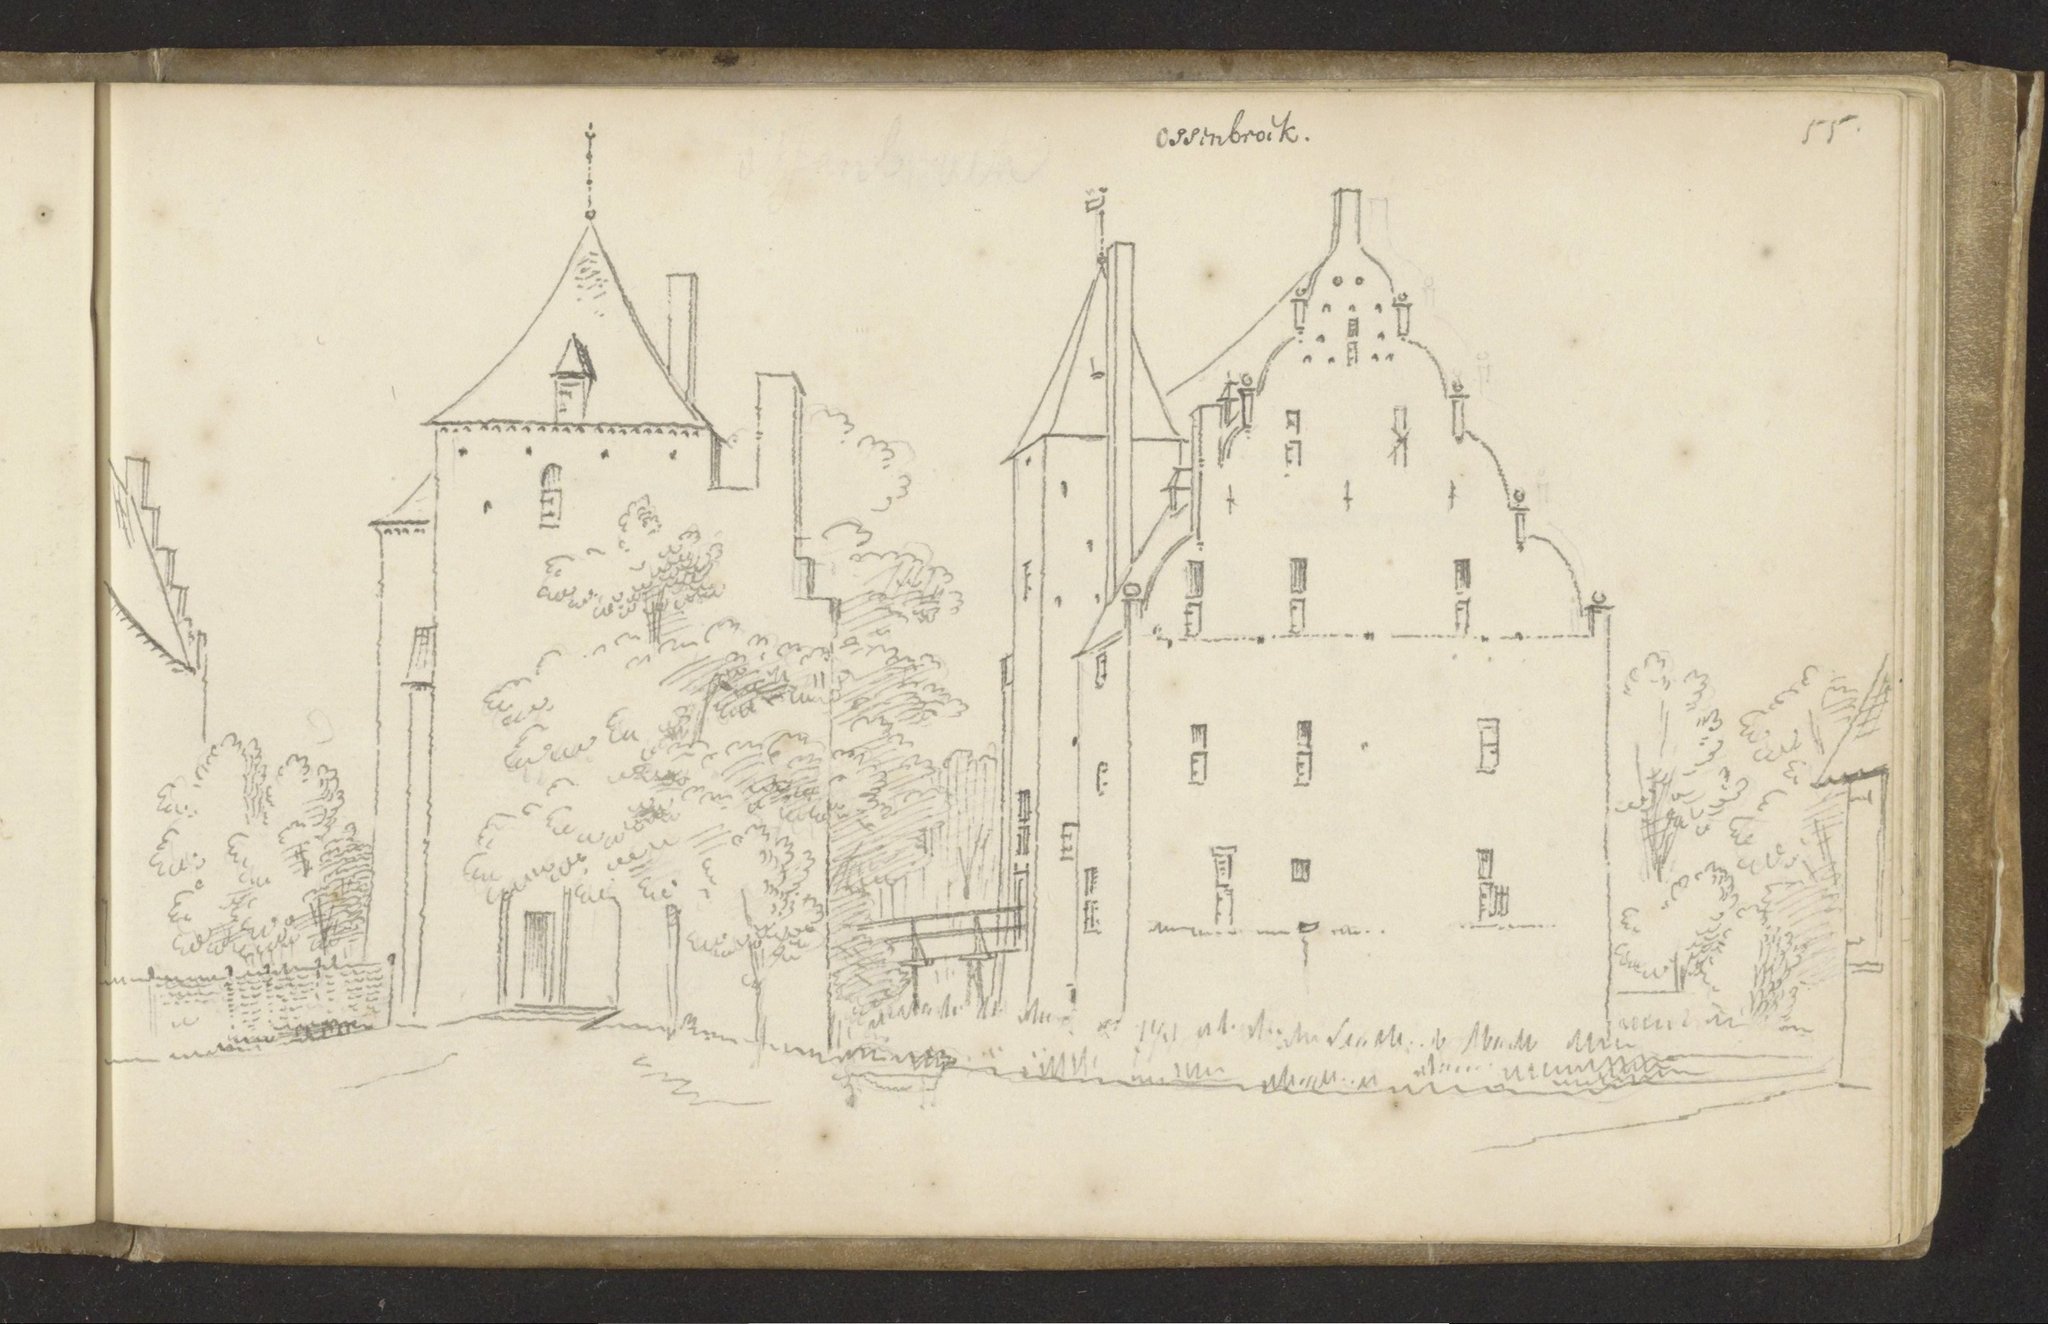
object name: sketchbook leaf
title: Kasteel Ossenbroek bij Kleef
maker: abraham de haen (ii)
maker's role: draughtsman, print maker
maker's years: 1707-1748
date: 1731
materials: ink, paper, pencil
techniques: pen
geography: cleves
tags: castle, cleves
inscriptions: annotation: ‘Ossenbroek’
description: Blad 55 recto uit een schetsboek met 69 bladen.